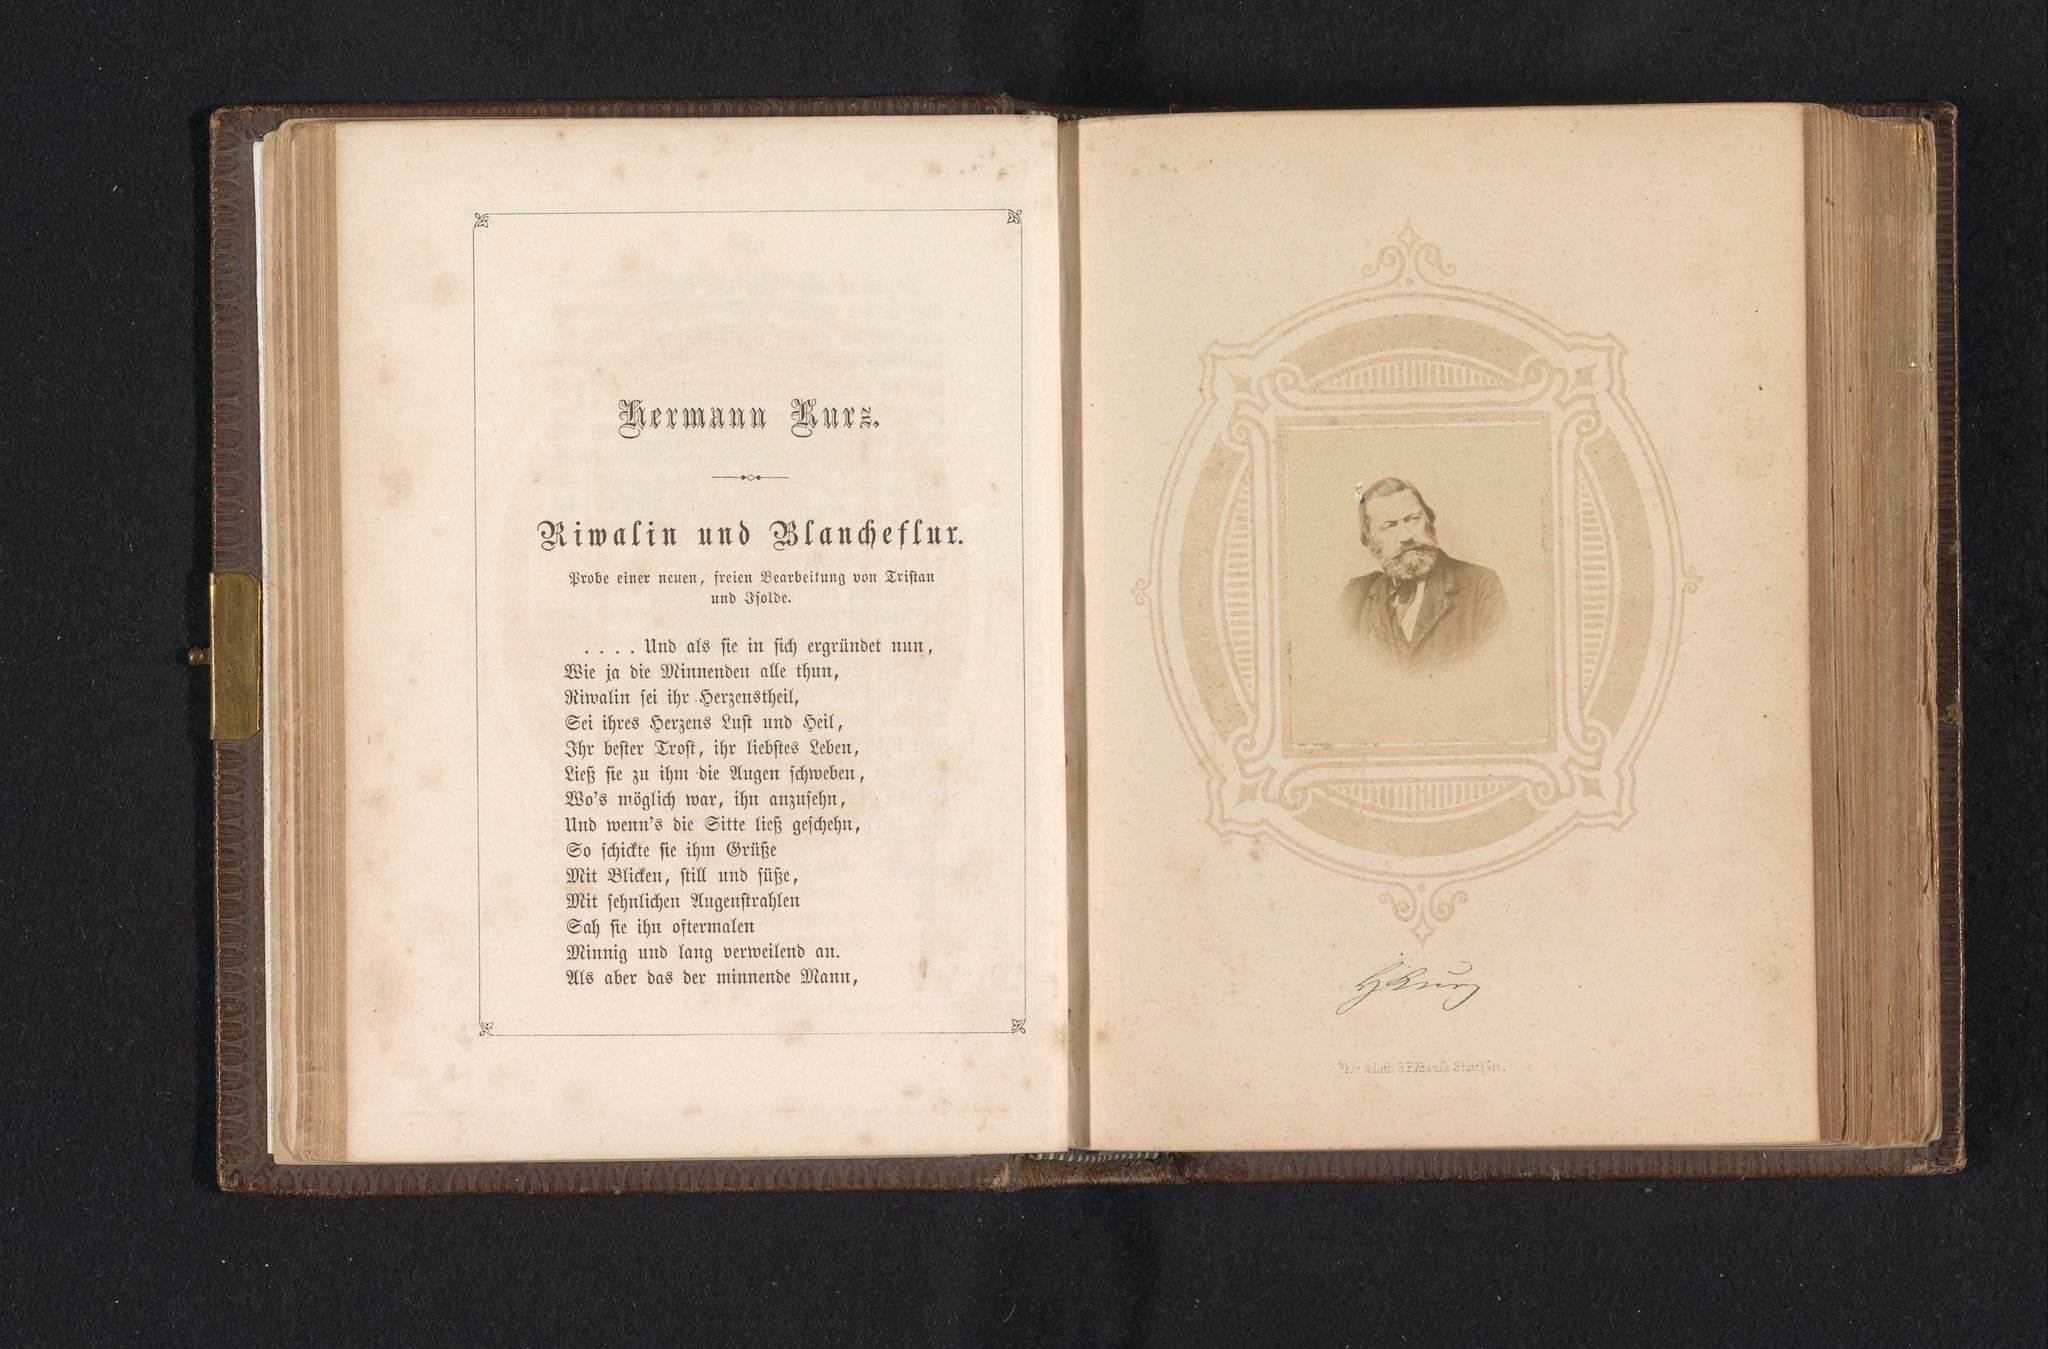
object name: photograph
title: Portret van Hermann Kurz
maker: g.f. krauss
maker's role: fotograaf, lithograaf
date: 1854-1864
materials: photographic support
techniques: albumen print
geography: germany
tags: writer, poet, author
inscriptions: name